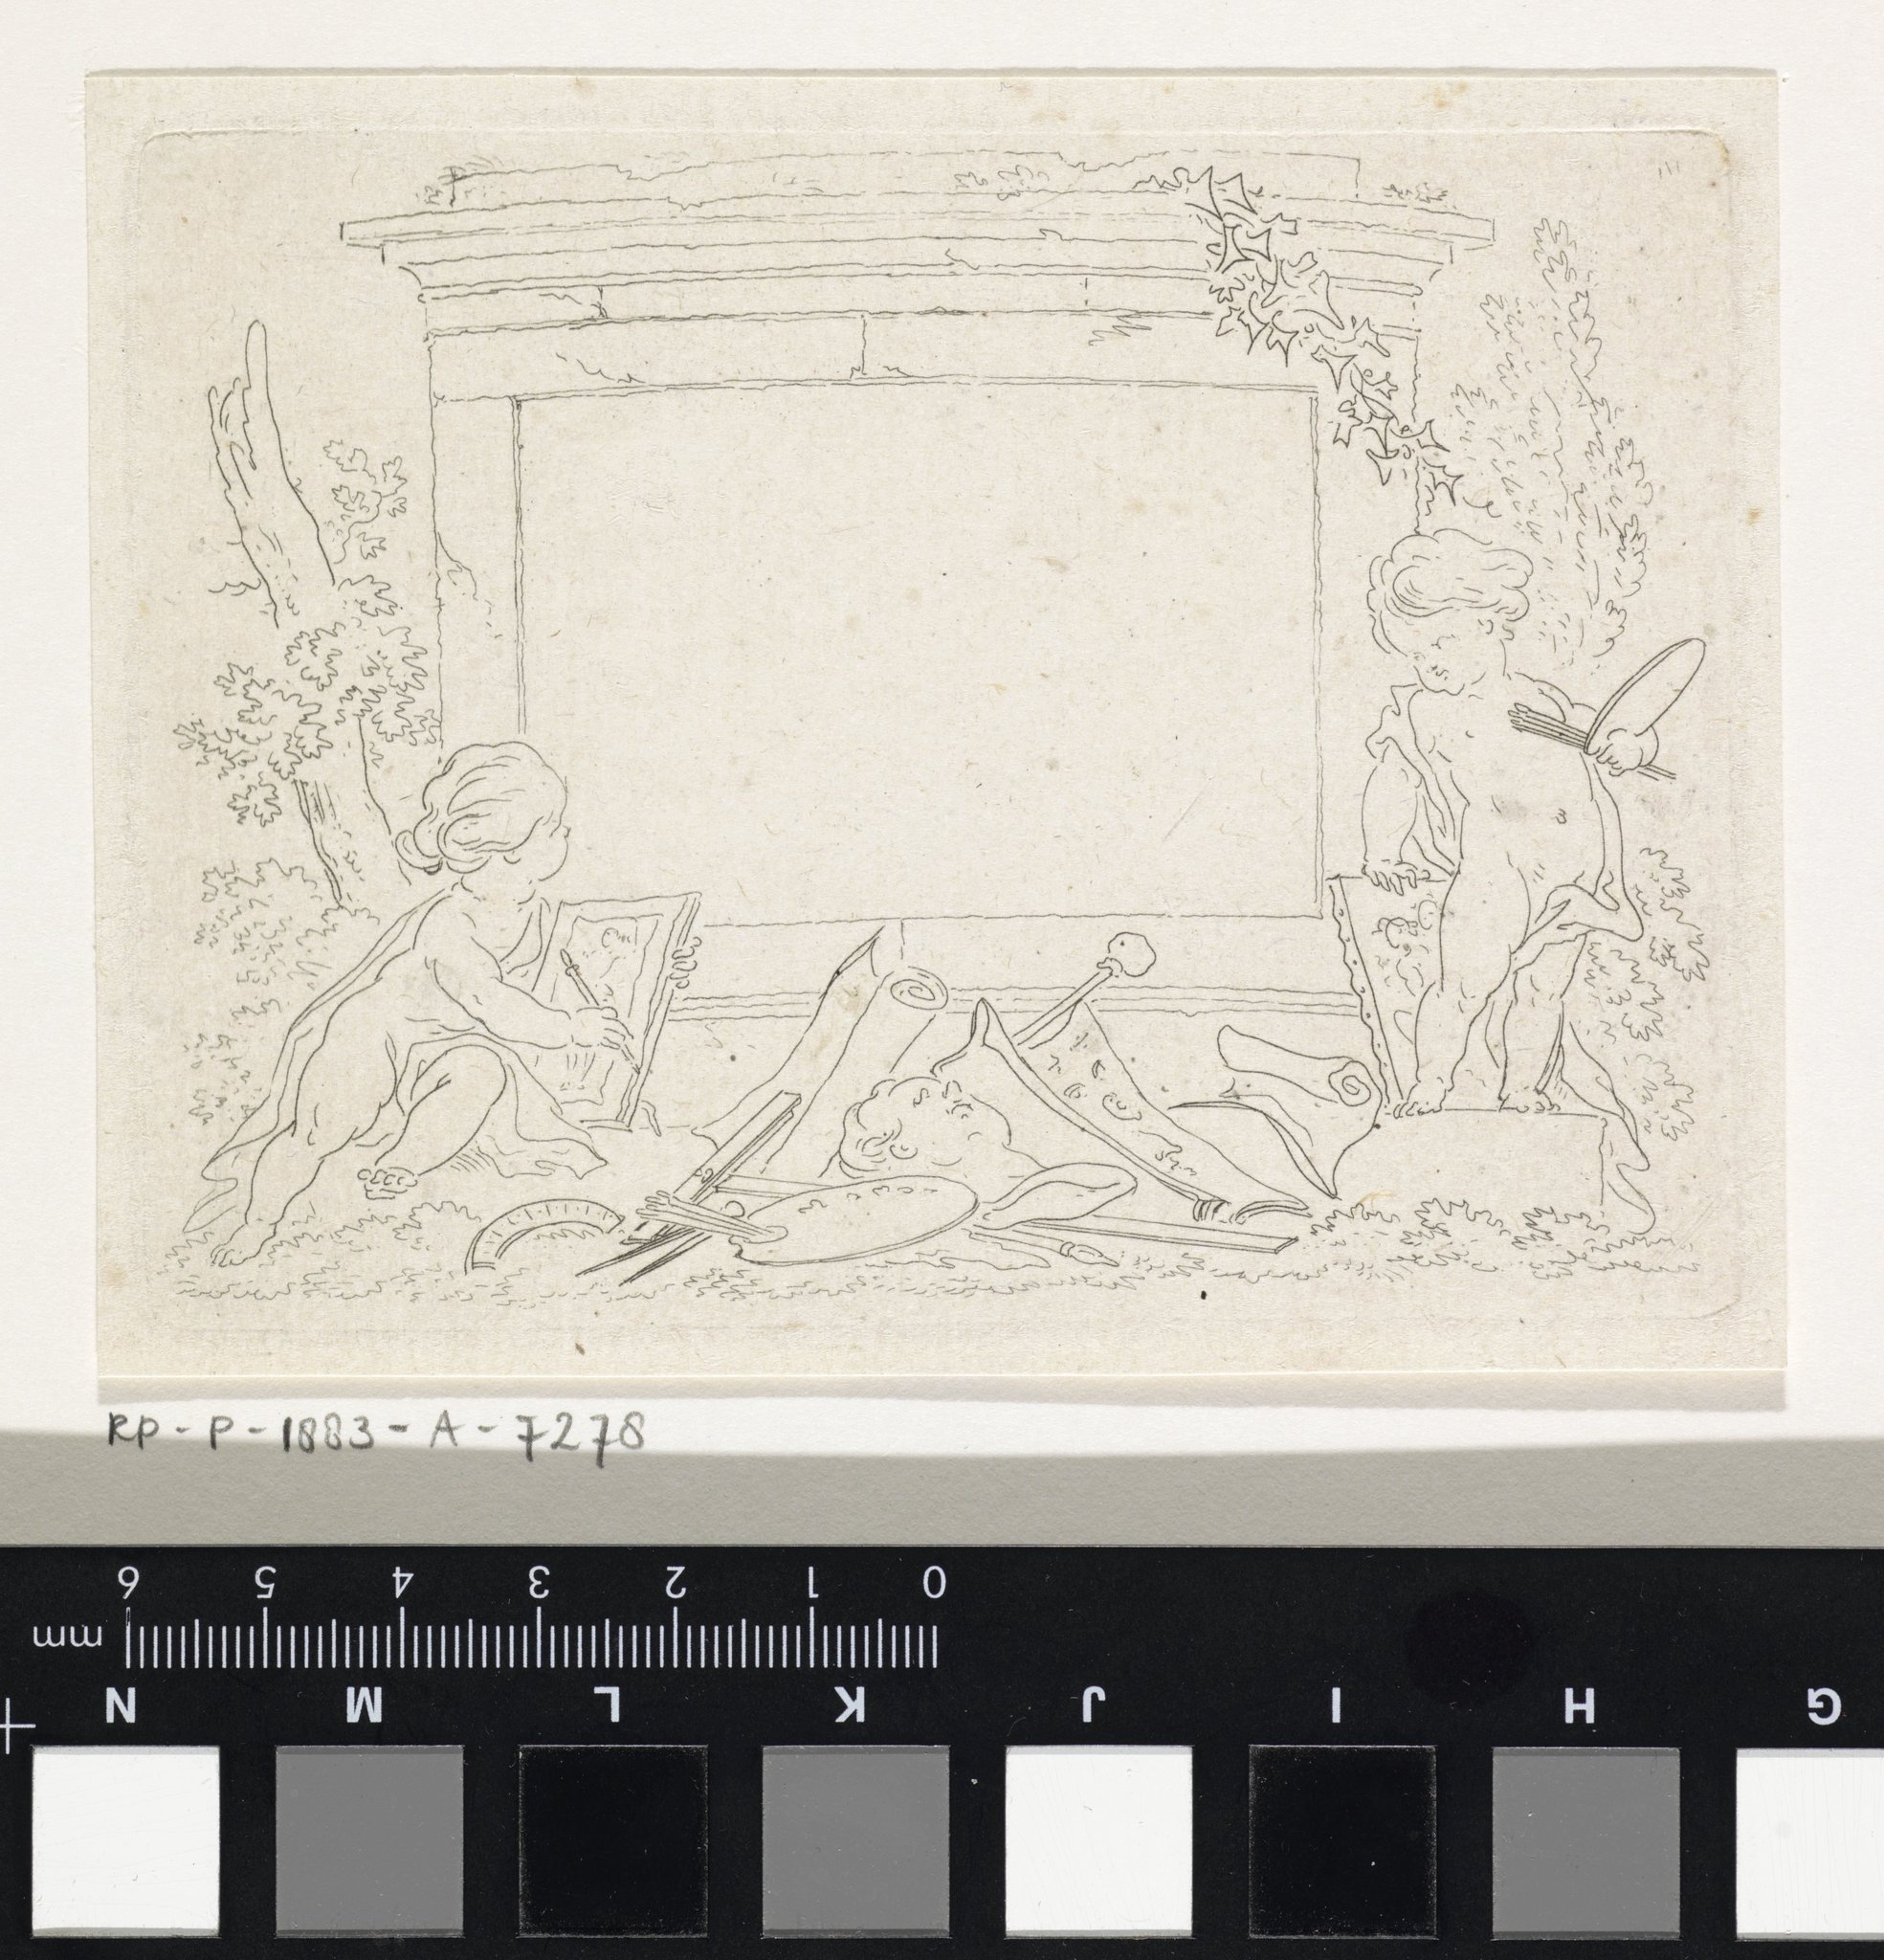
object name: print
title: Vignet met teken- en schildergerei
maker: derk anthony van de wart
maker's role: draughtsman, painter, print maker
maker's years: 1767-1824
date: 1782-1824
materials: paper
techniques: etching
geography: northern netherlands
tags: drawing-instruments, painting ~ applied arts (+ materials ~ arts), base (~ column, pillar)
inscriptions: collector's mark: Lugt 2228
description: Voor een basement of sokkel zonder opschrift zijn twee putti weergegeven. De linker putto houdt een tekening en tekengerei vast en de rechter putto staat bij een beschilderd doek met een palet en penselen in de hand. Tussen hen in liggen verschillende teken- en schilderbenodigdheden.